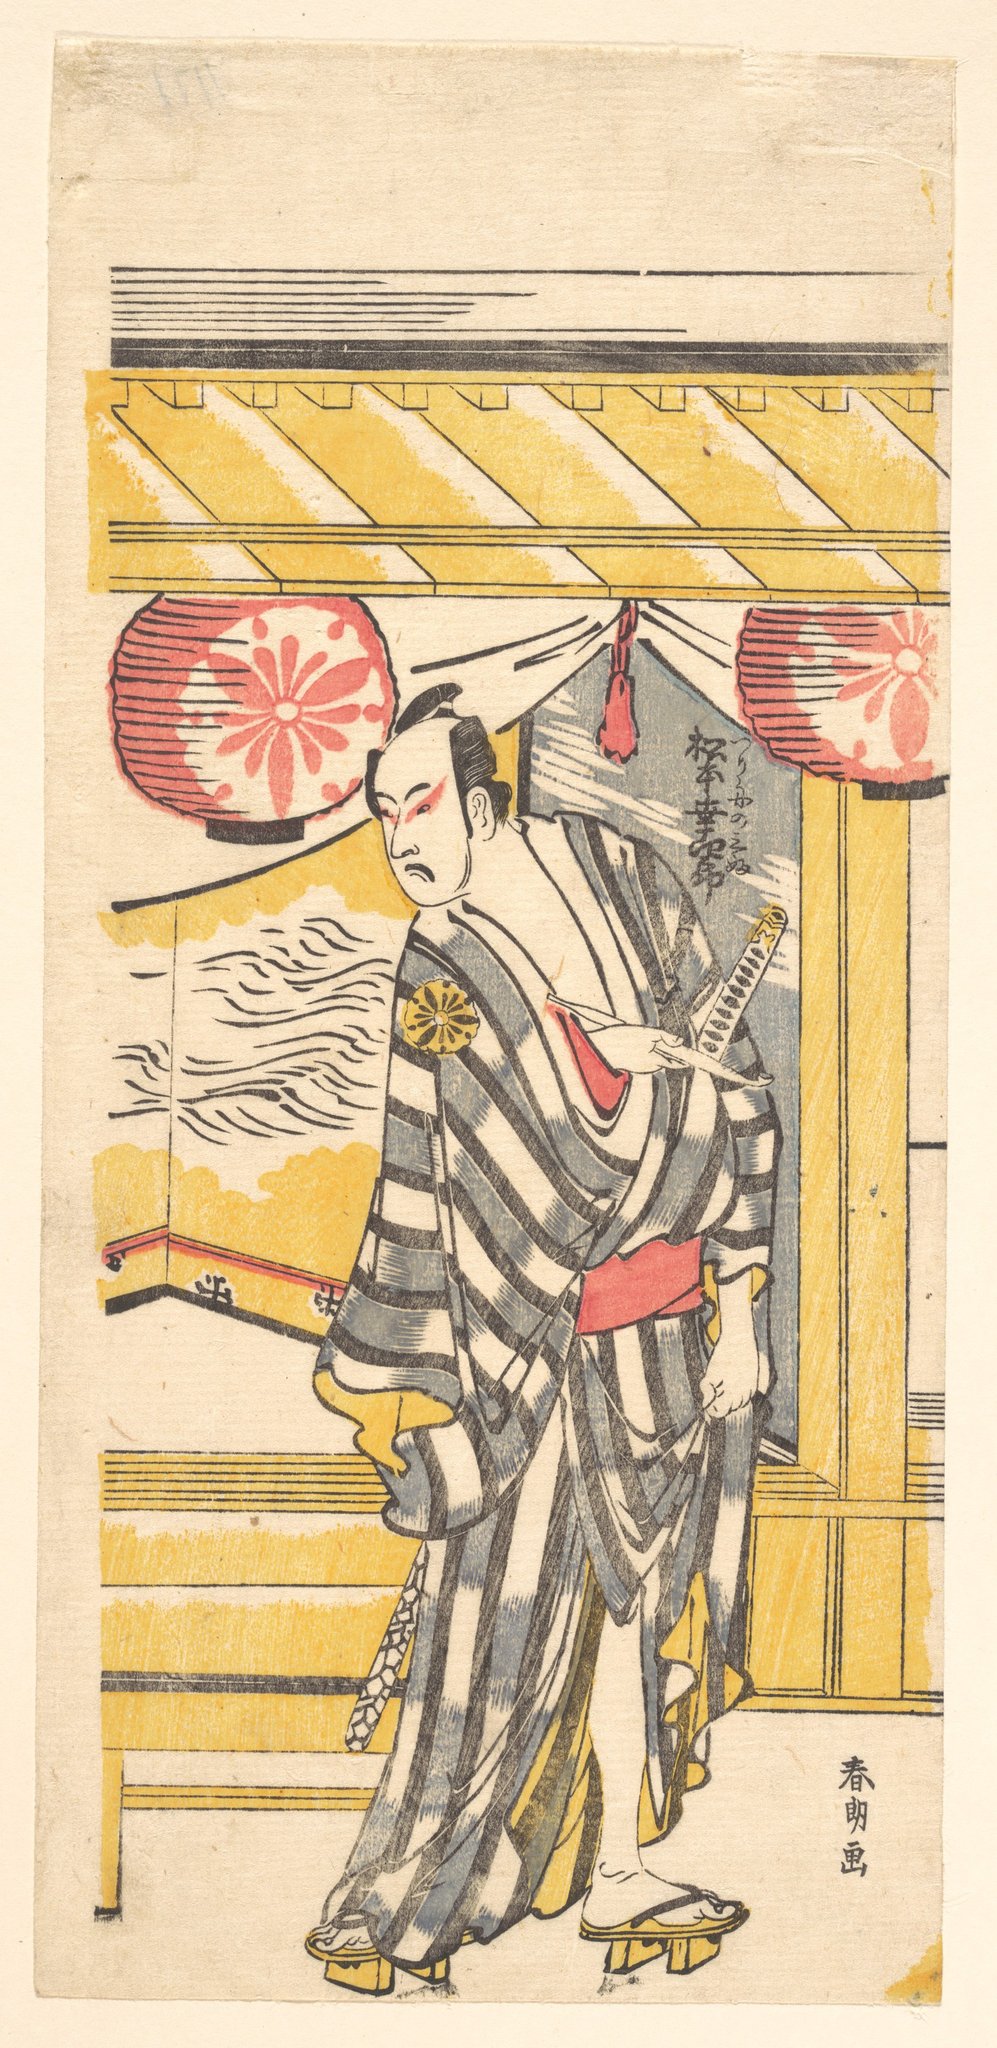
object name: woodblock print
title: Matsumoto Koshiro IV as Tsurifune no Sabu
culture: japanese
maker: katsushika hokusai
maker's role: artist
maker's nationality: japanese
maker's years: 1760-1849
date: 1796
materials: ink, paper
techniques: woodblock print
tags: swords,men,actors